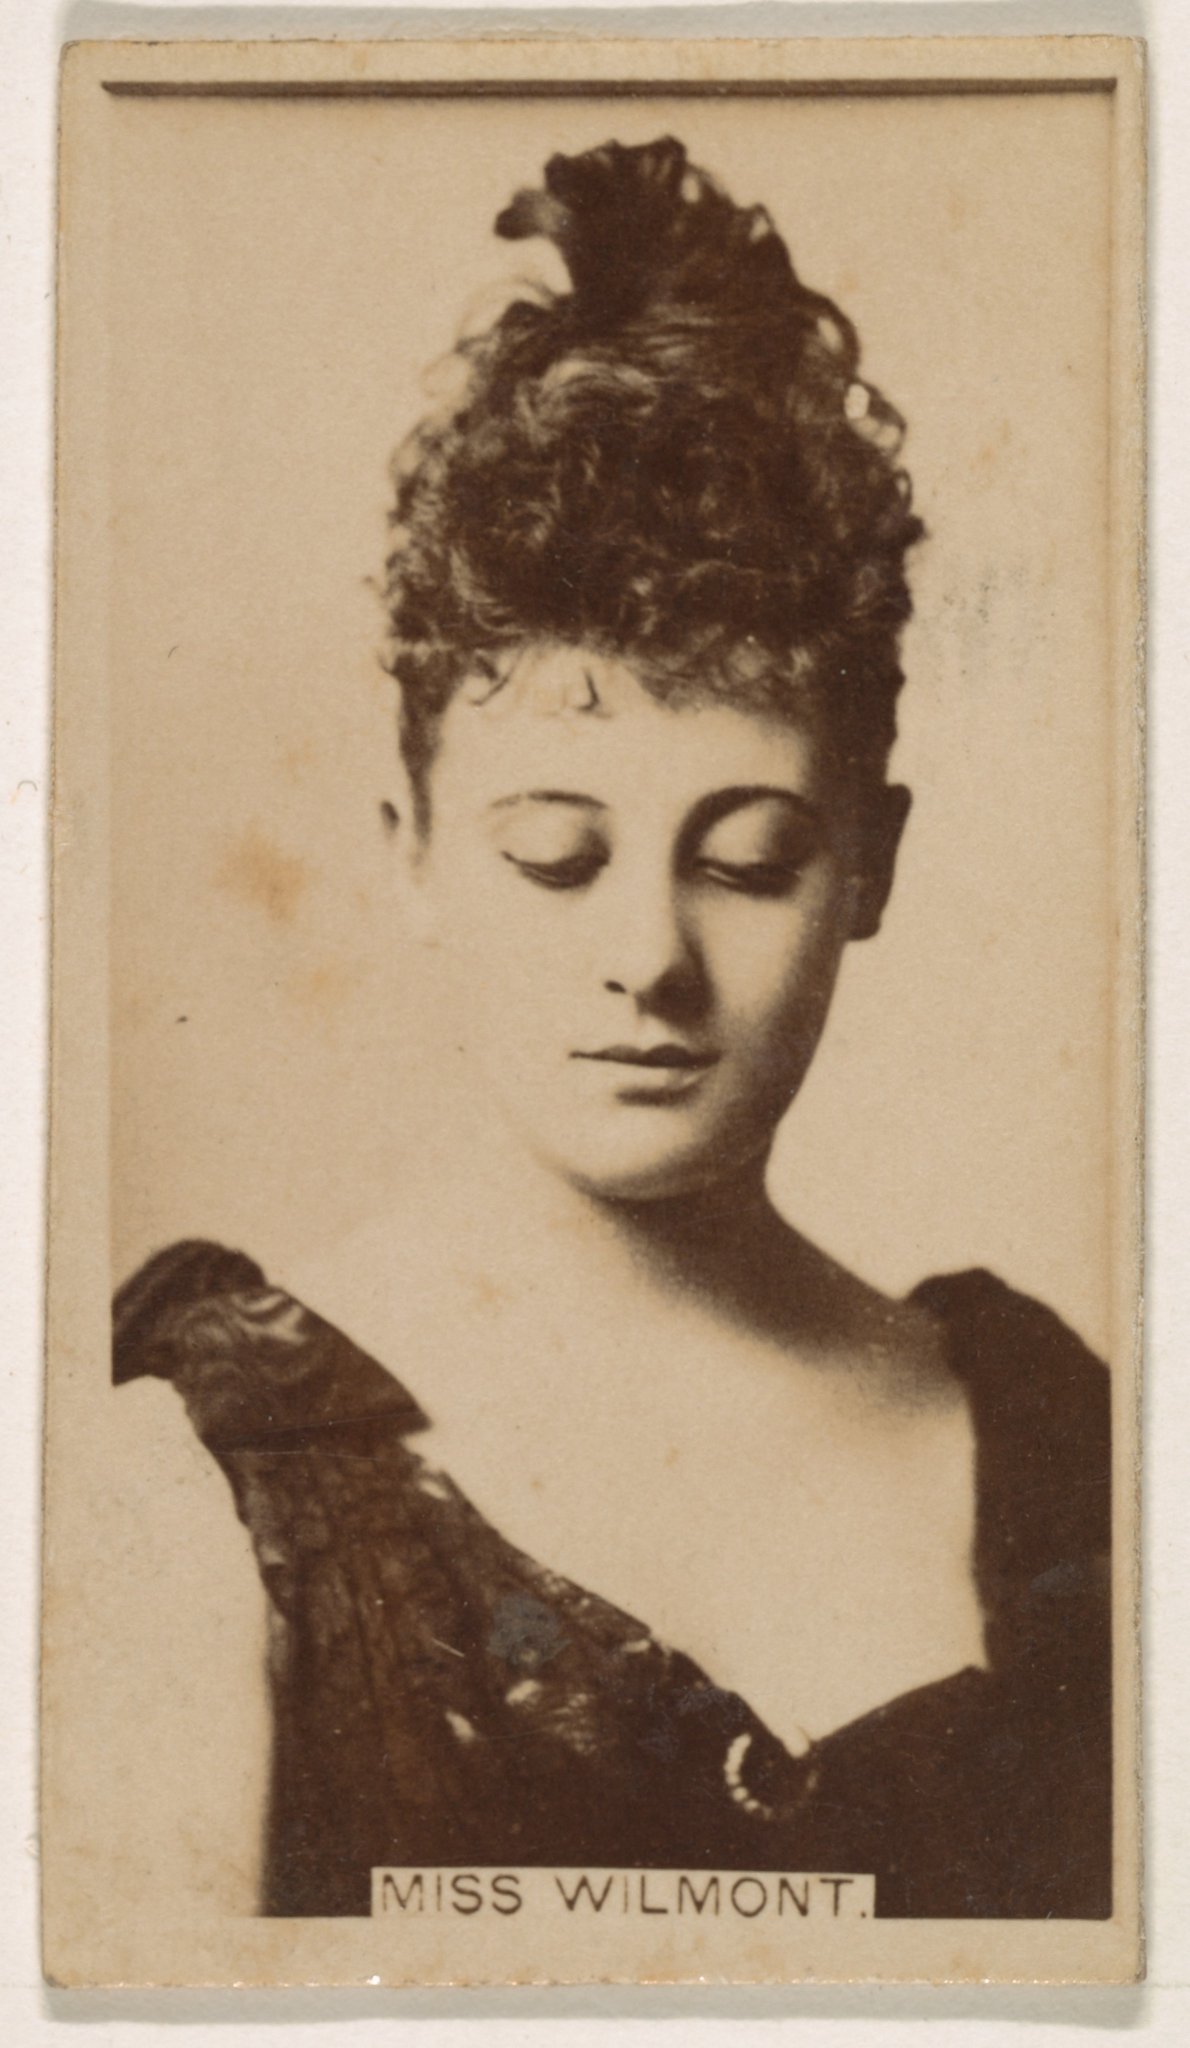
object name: photograph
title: Miss Wilmont, from the Actresses series (N245) issued by Kinney Brothers to promote Sweet Caporal Cigarettes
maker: kinney brothers tobacco company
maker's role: publisher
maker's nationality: american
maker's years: 1869-2011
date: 1890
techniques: albumen silver print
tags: portraits,women,actresses